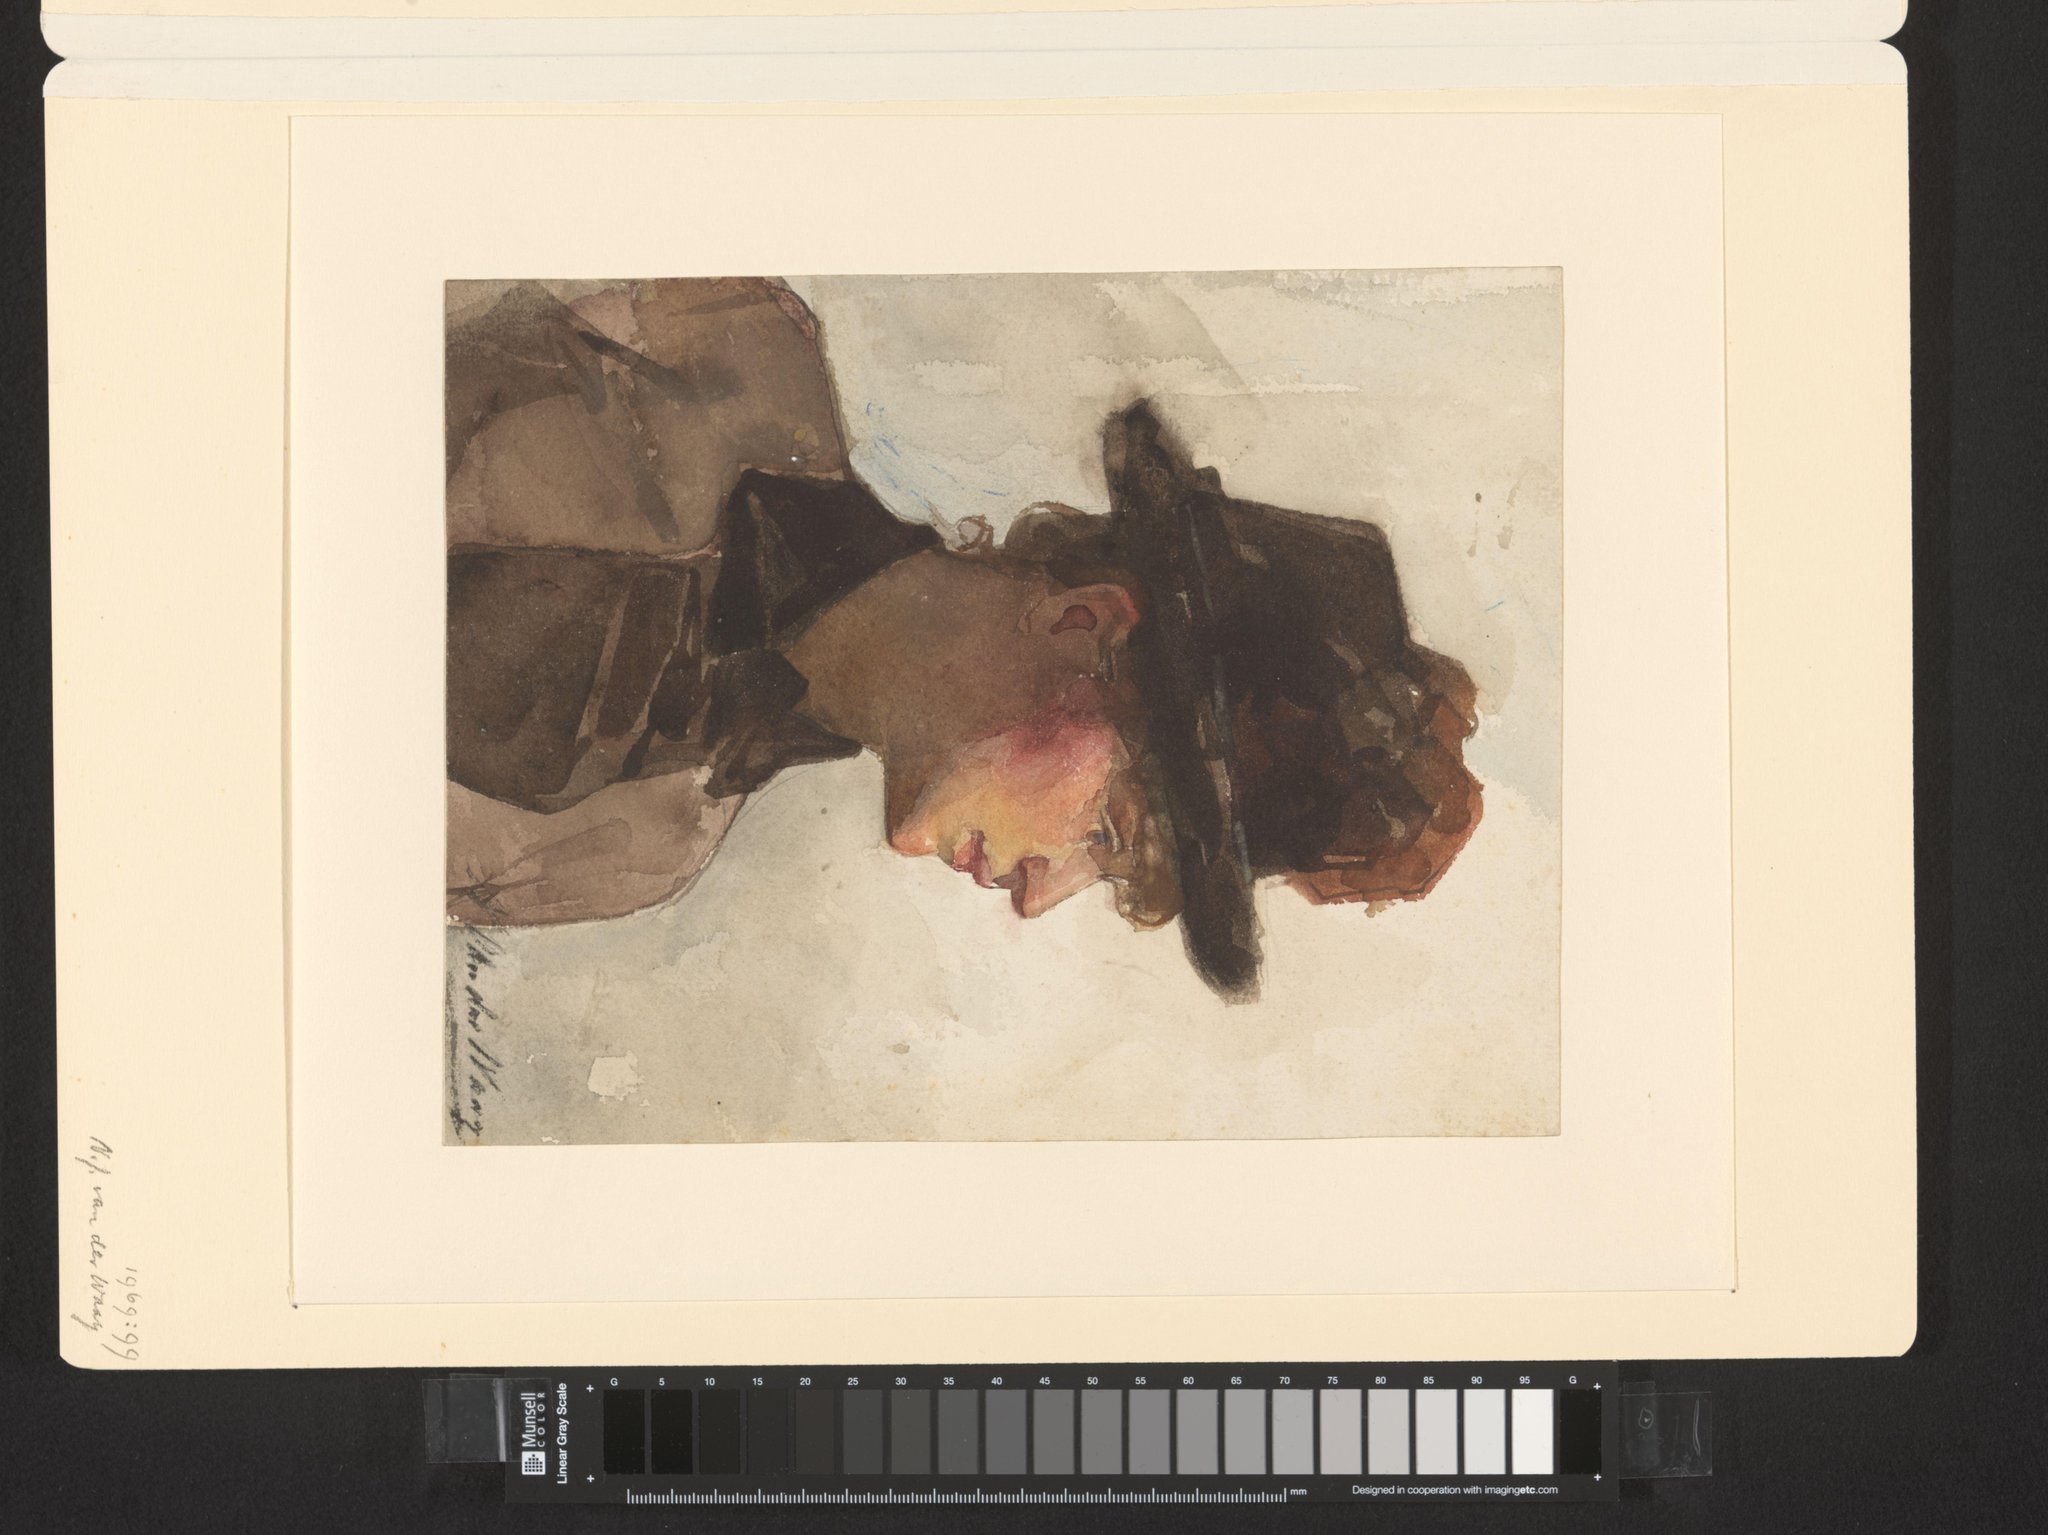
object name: drawing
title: Damesportret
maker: nicolaas van der waay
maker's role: draughtsman, painter, print maker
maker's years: 1855-1936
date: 1865-1936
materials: paper, pencil, watercolor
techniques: brush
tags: female sex; woman, anonymous historical person portrayed